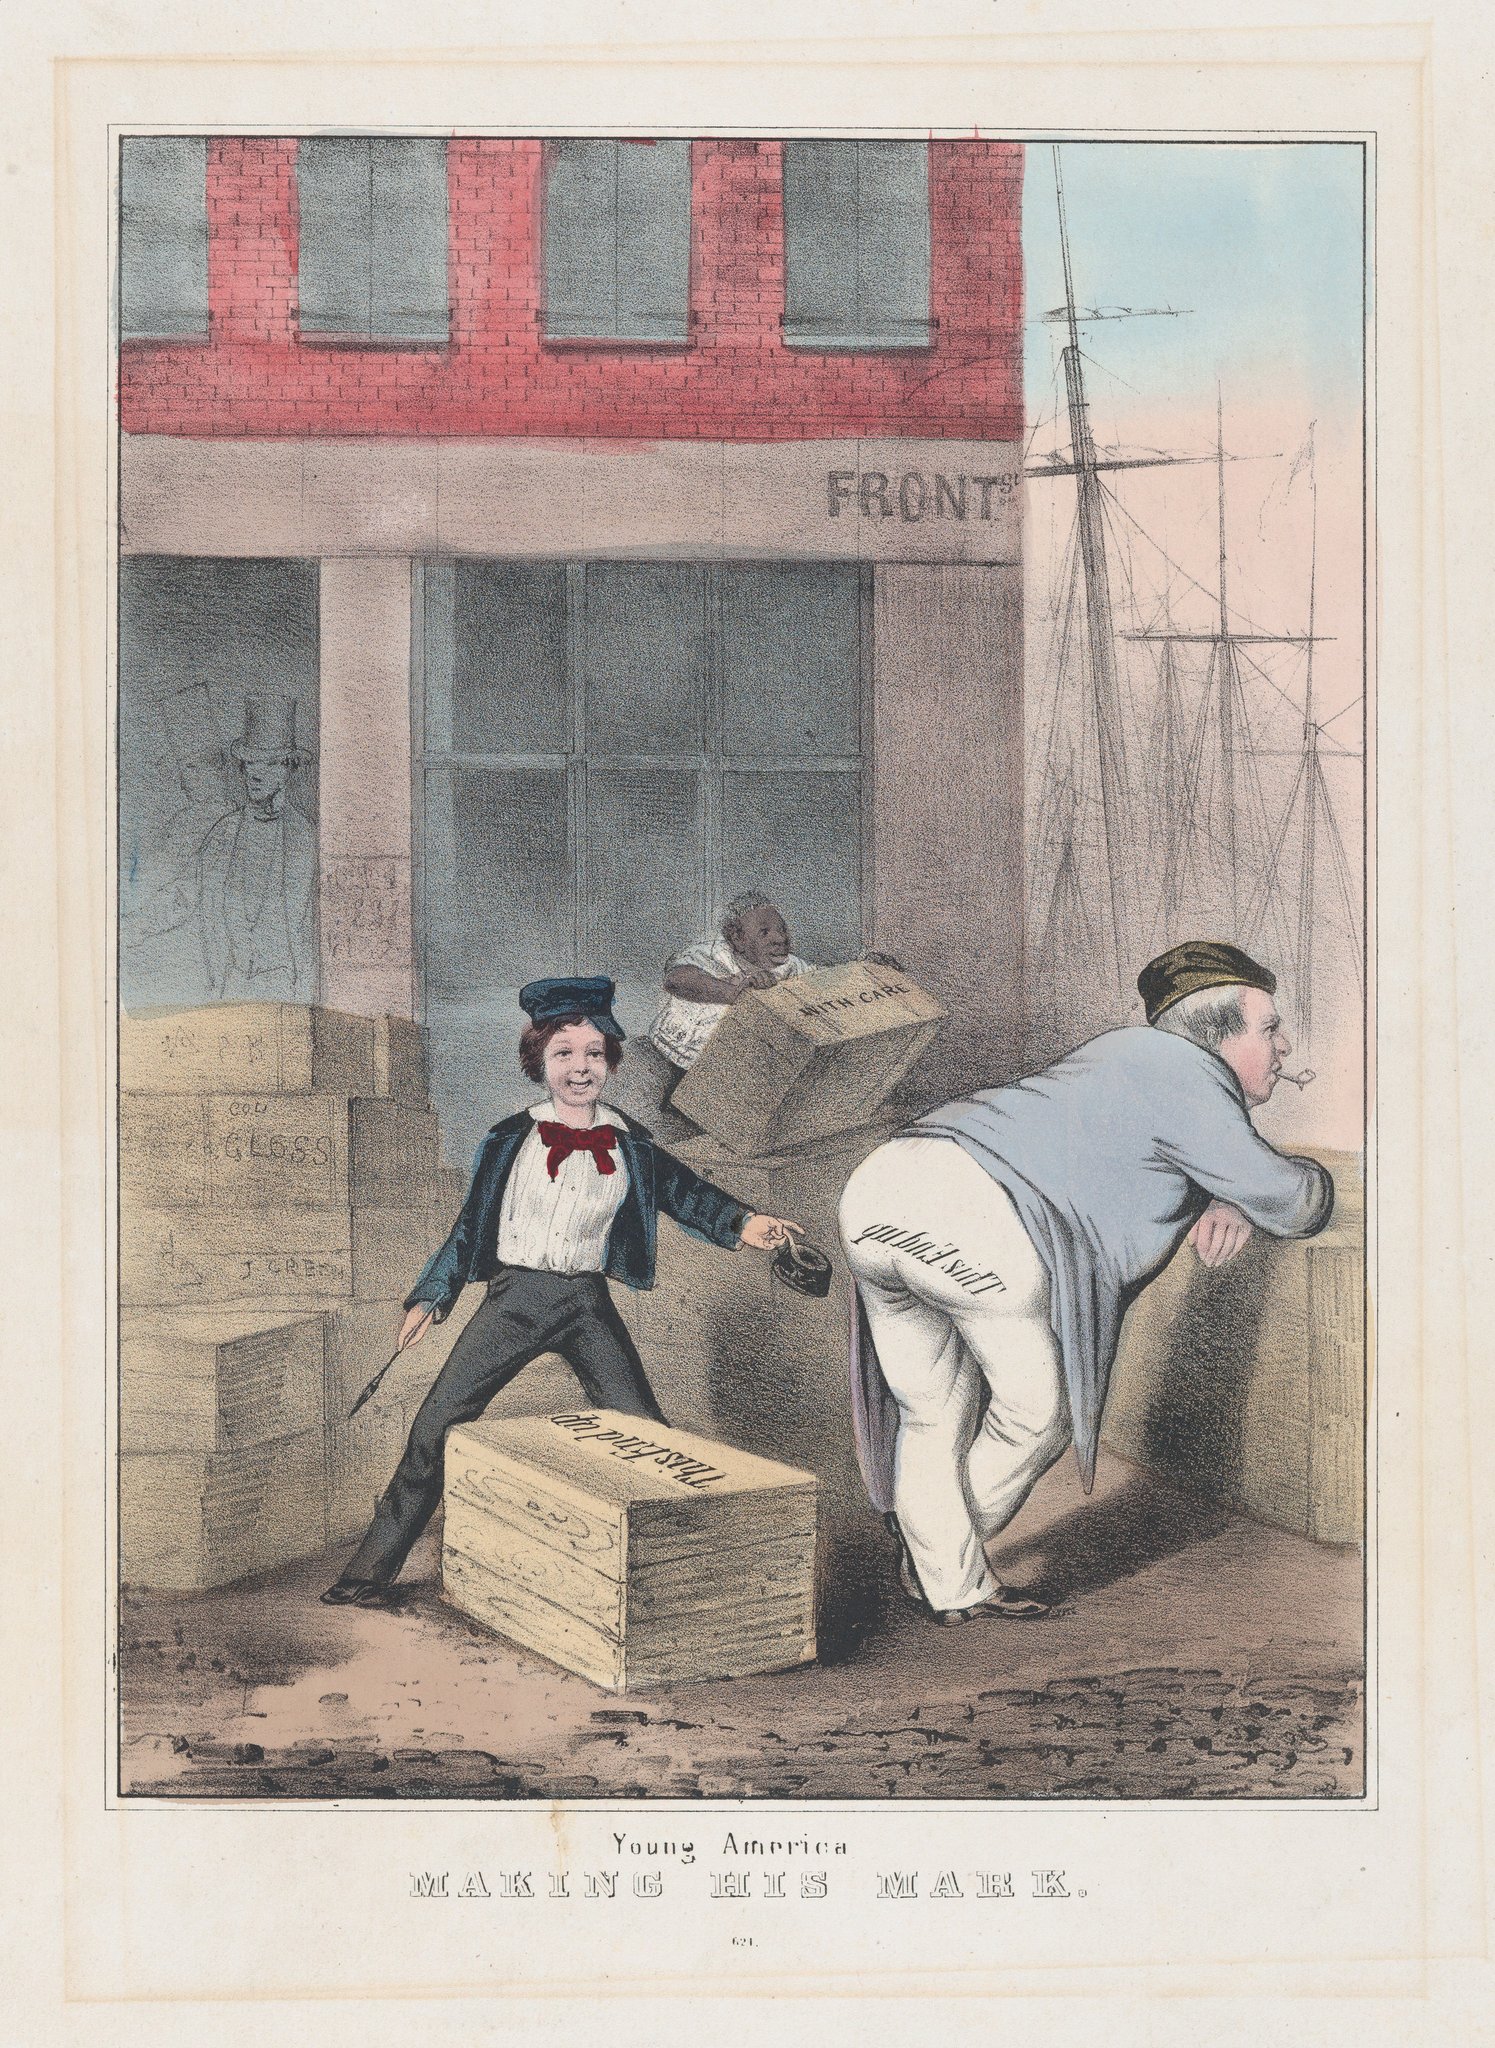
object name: print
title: Young America Making His Mark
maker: anonymous, american, 19th century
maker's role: artist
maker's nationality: american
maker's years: 1800-1900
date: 1840-1849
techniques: lithograph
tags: boys,men